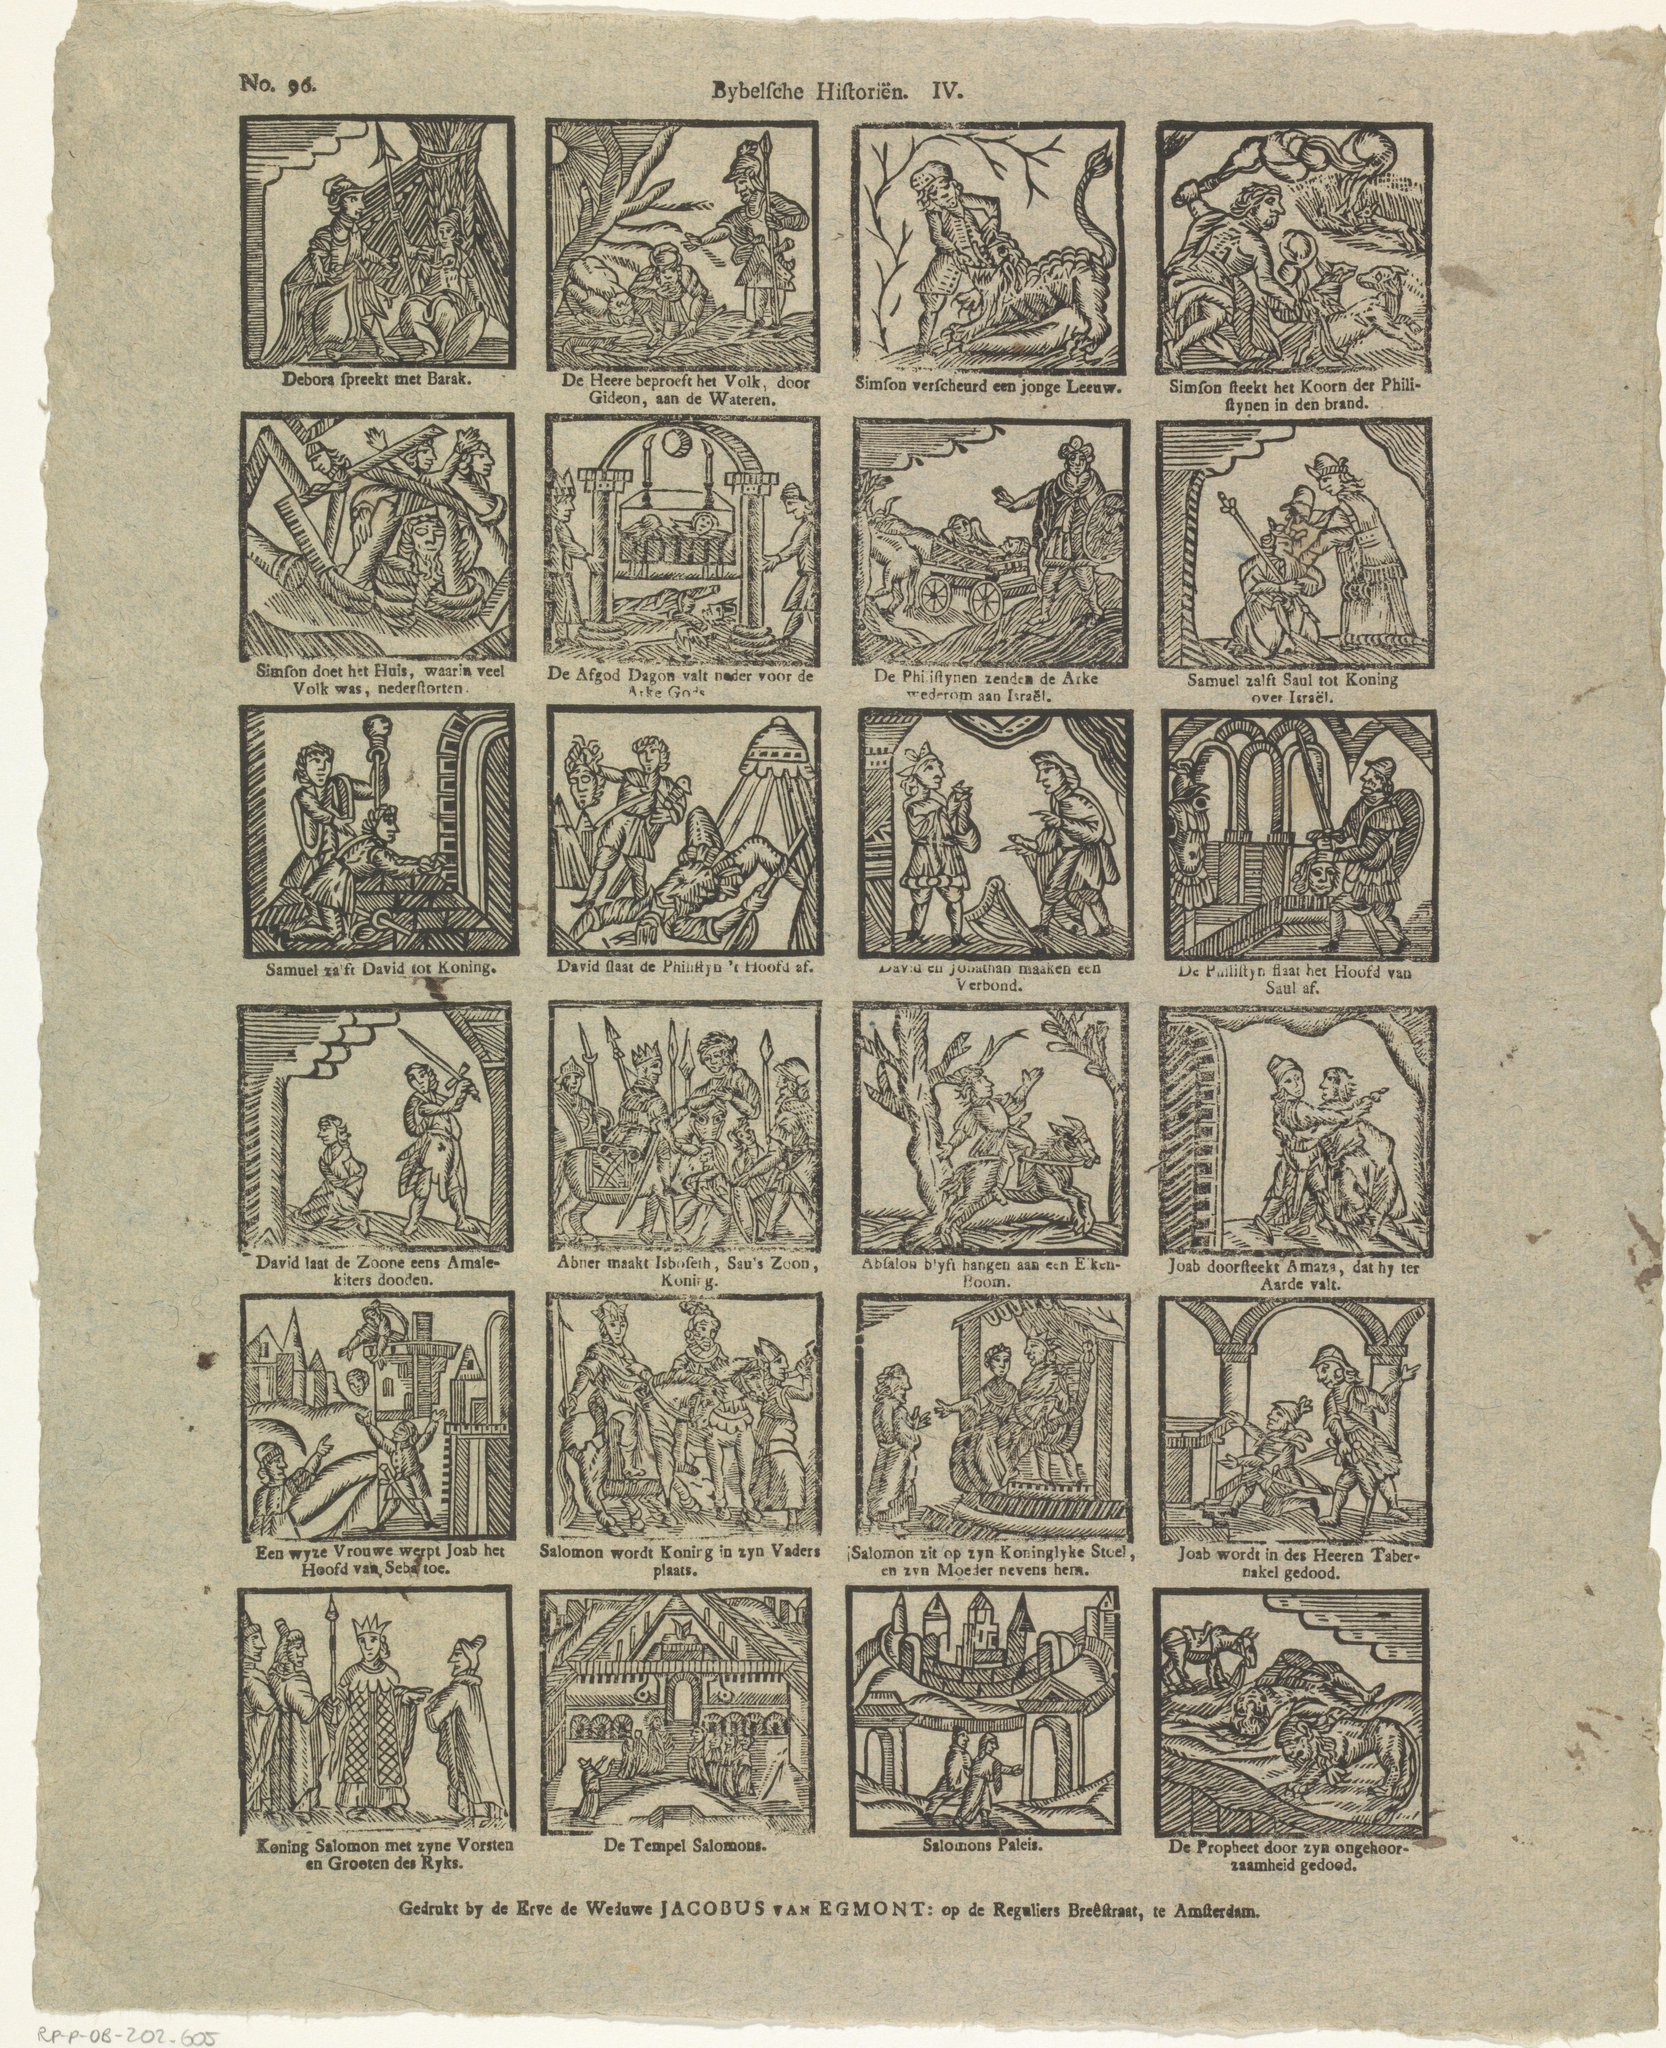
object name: popular print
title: Bybelsche historiën. IV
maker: Anonymous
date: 1761-1804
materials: paper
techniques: letterpress printing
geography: amsterdam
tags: old testament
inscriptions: collector's mark: Lugt 2760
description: Blad met 24 voorstellingen uit het Oude Testament, waaronder Simson doodt de leeuw, Samuël zalft David tot koning en de Tempel van Salomo. Onder elke afbeelding een onderschrift. Genummerd linksboven: No. 96.